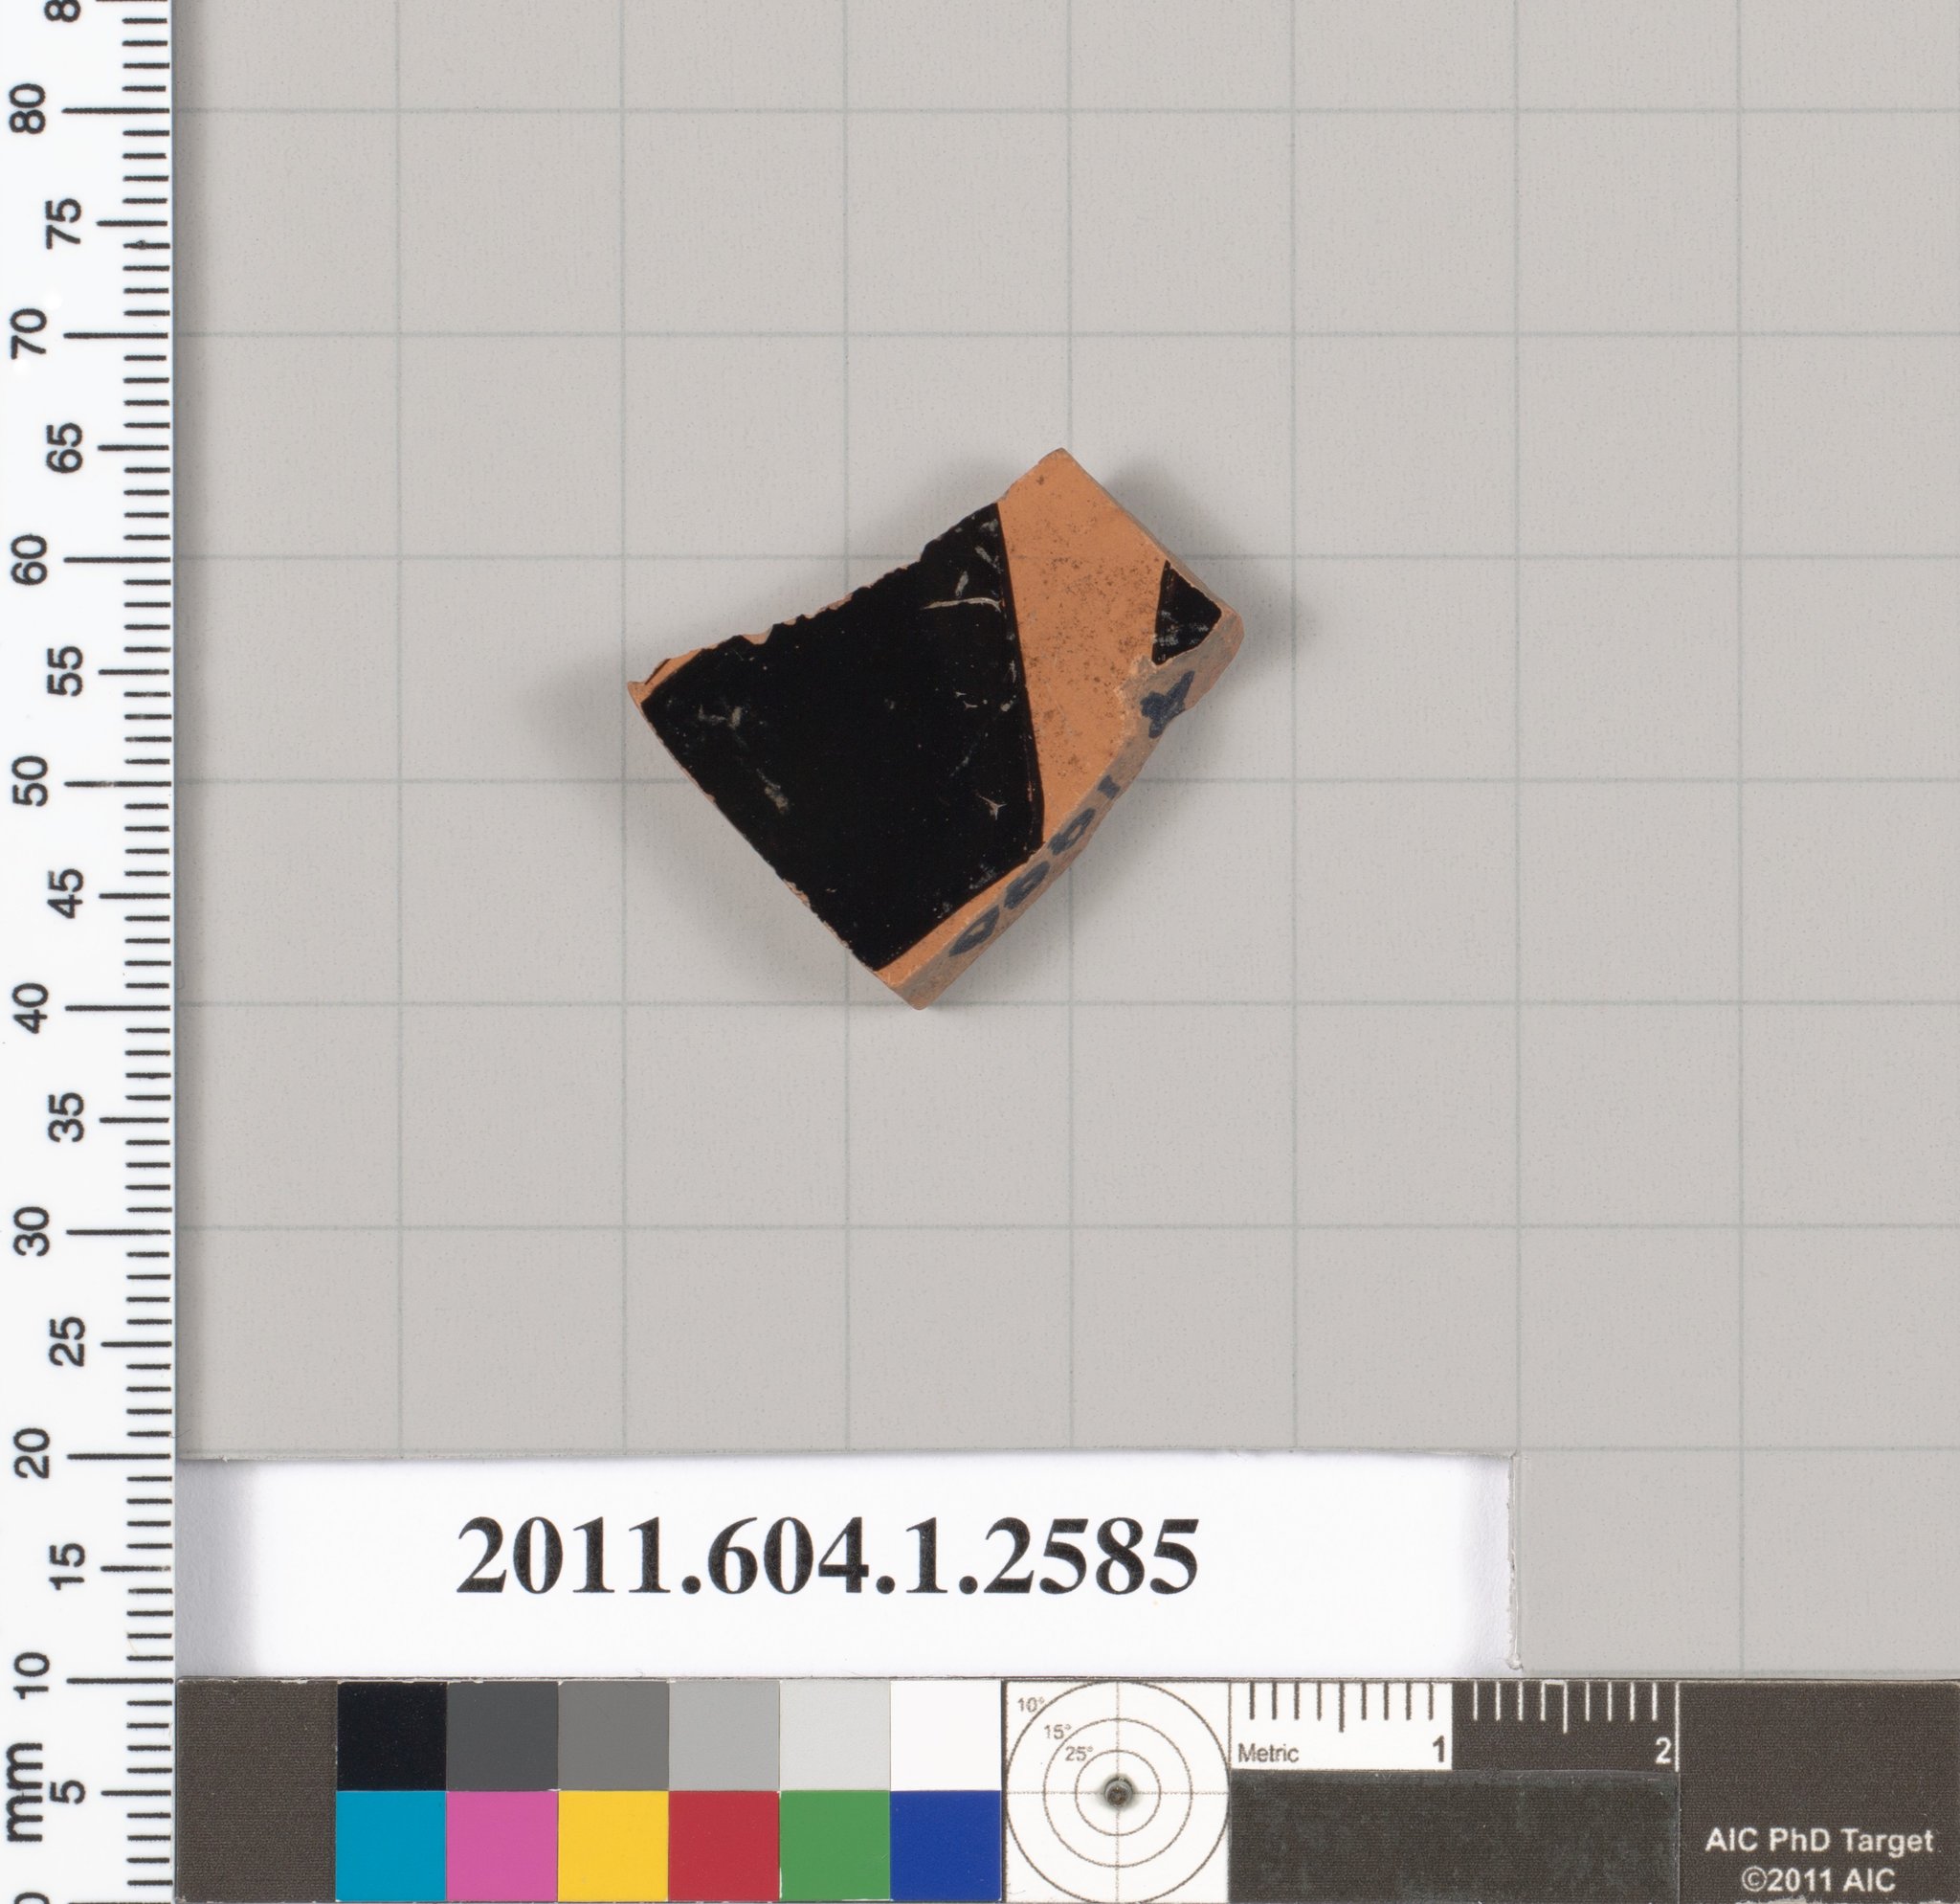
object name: kylix fragment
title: Terracotta fragment of a kylix (drinking cup)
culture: greek, attic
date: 490-480 BCE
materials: terracotta